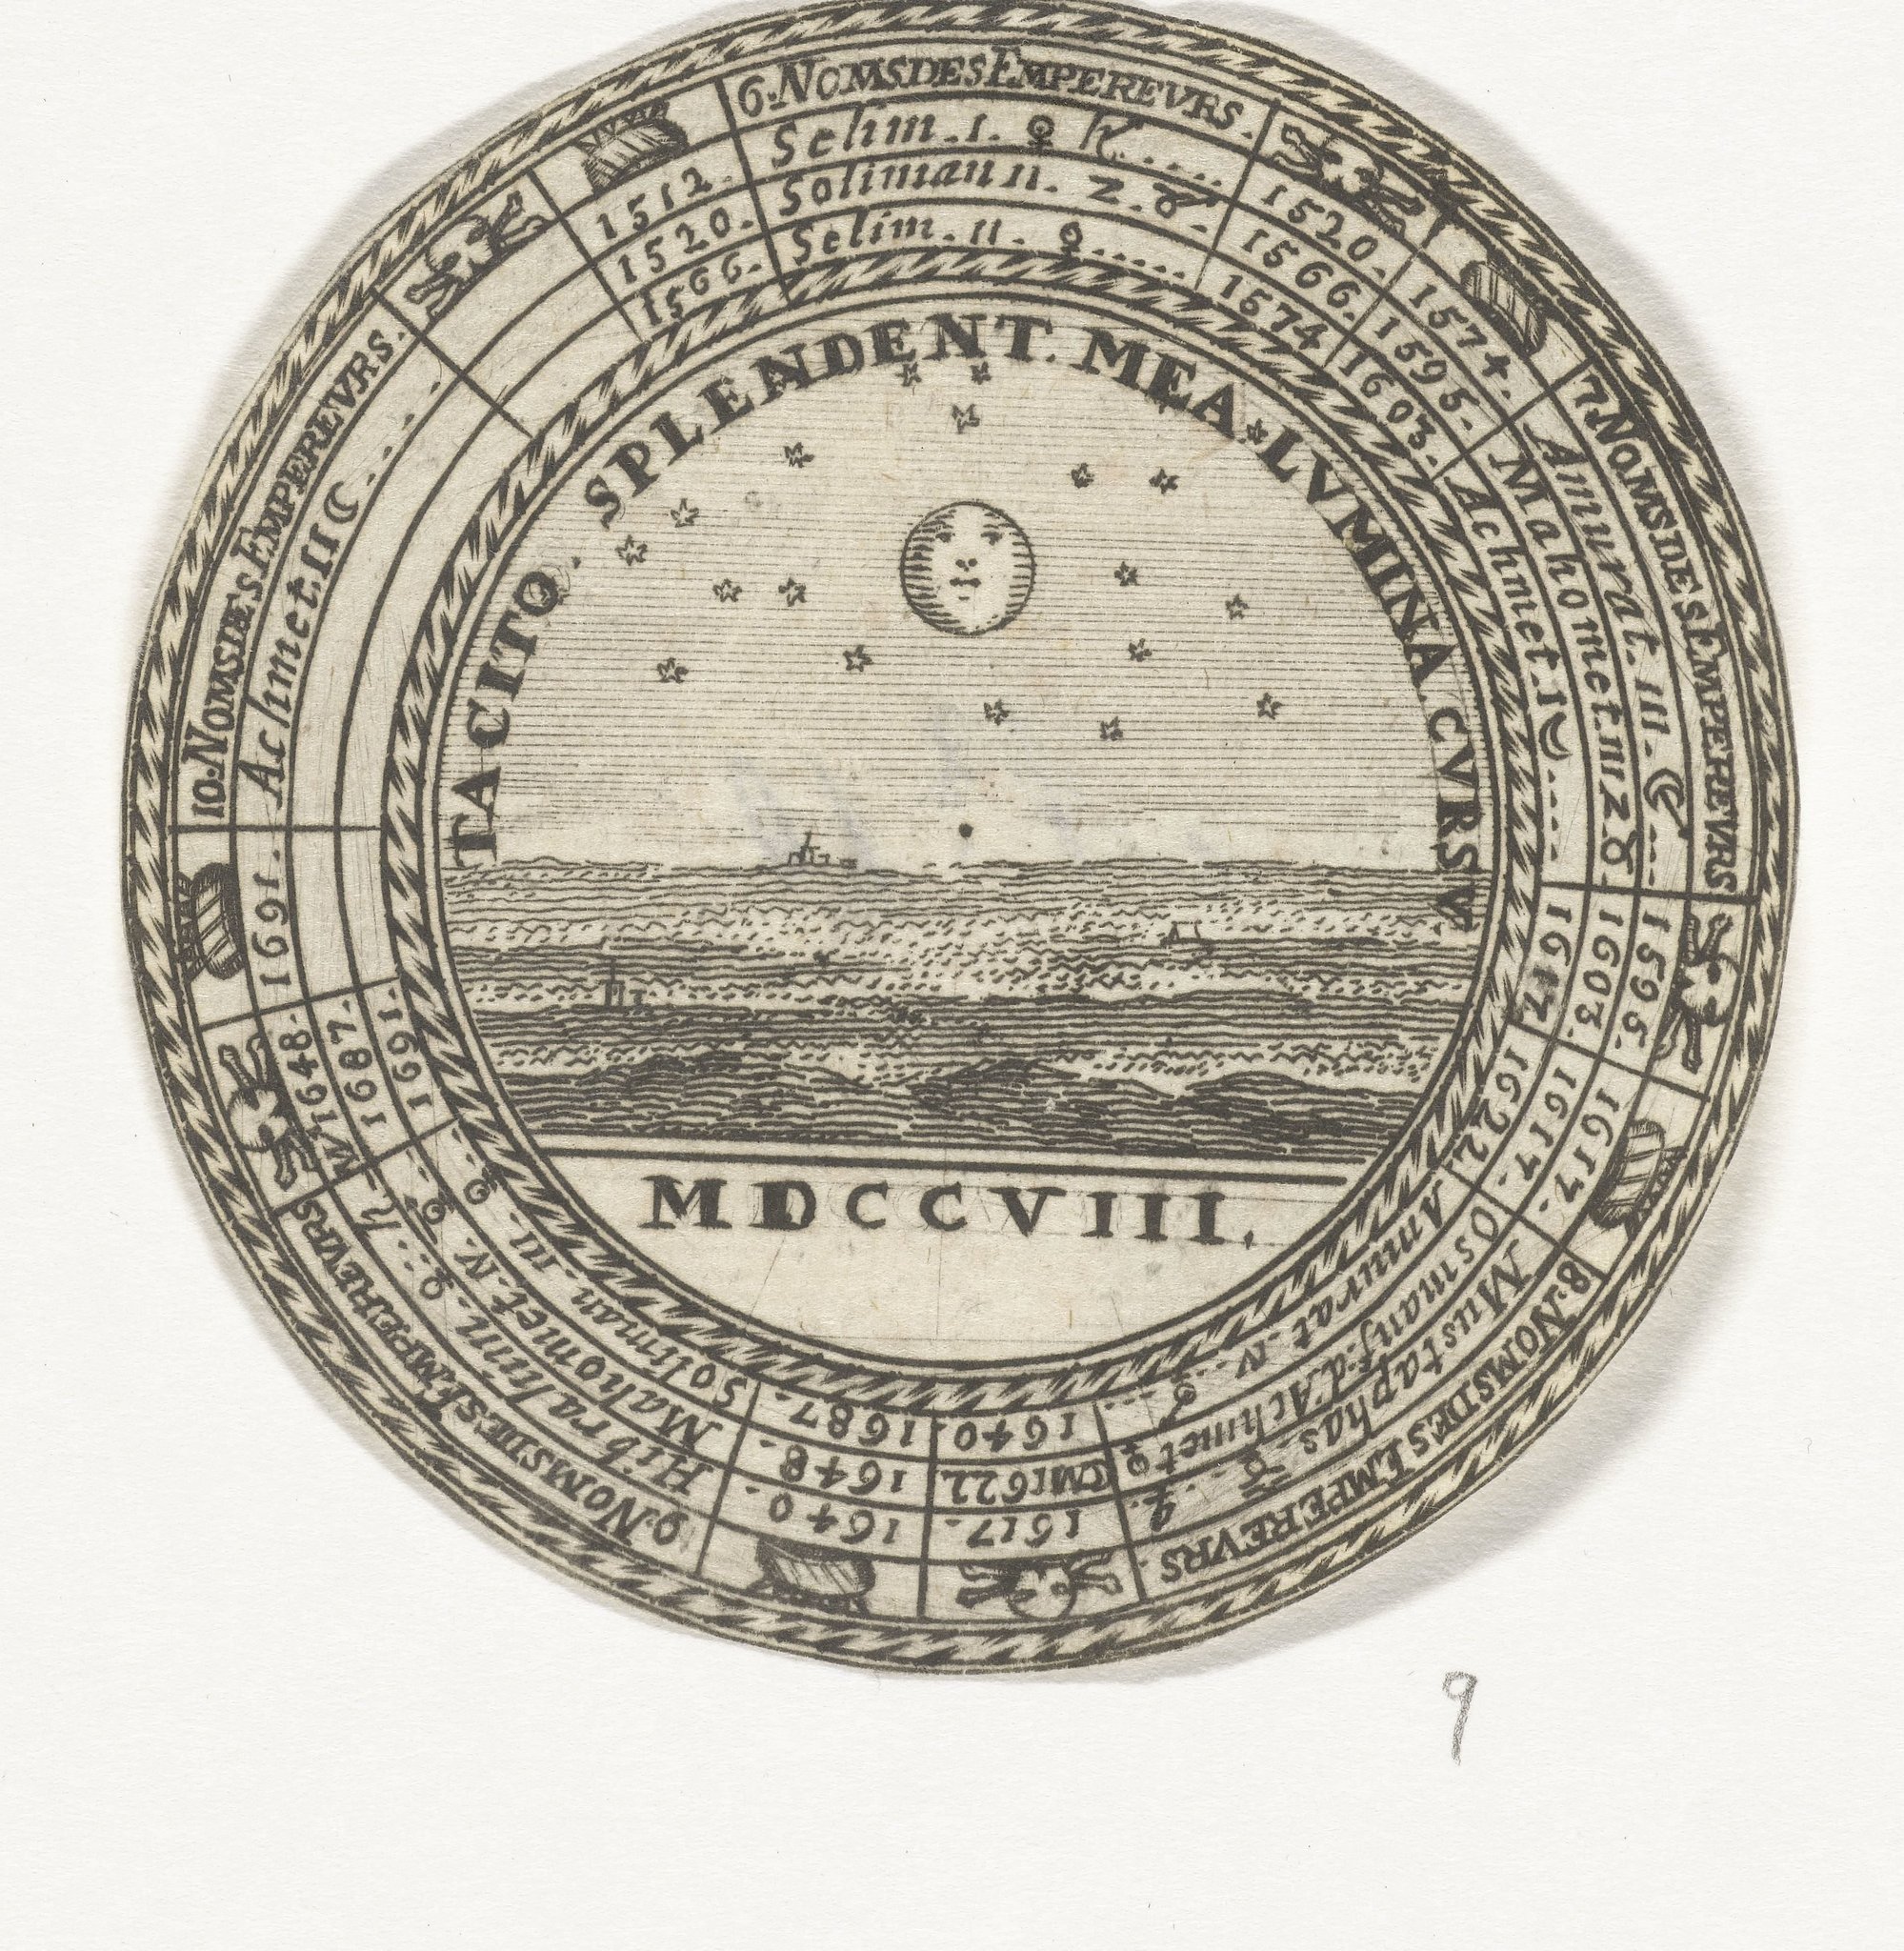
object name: print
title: Penning met een embleem en met de namen van de Ottomaanse sultans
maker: Anonymous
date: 1708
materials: paper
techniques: etching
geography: amsterdam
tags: sea (seascape), device (as symbol of the state, etc.), abstract ideas and concepts (+ emblematical representation of concept), seal (symbol of sovereignty), other sovereign (with title)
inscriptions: number: ‘4’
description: Ontwerp van een ronde penning met, in vier concentrische cirkels, de namen van Ottomaanse sultans en hun regeringsjaren, beginnende bij sultan Selim I en eindigend bij Sultan Ahmed II. In het midden van de penning een embleem met een zeelandschap en het motto: "Tacito Splendent Mea Lumina Cursu".